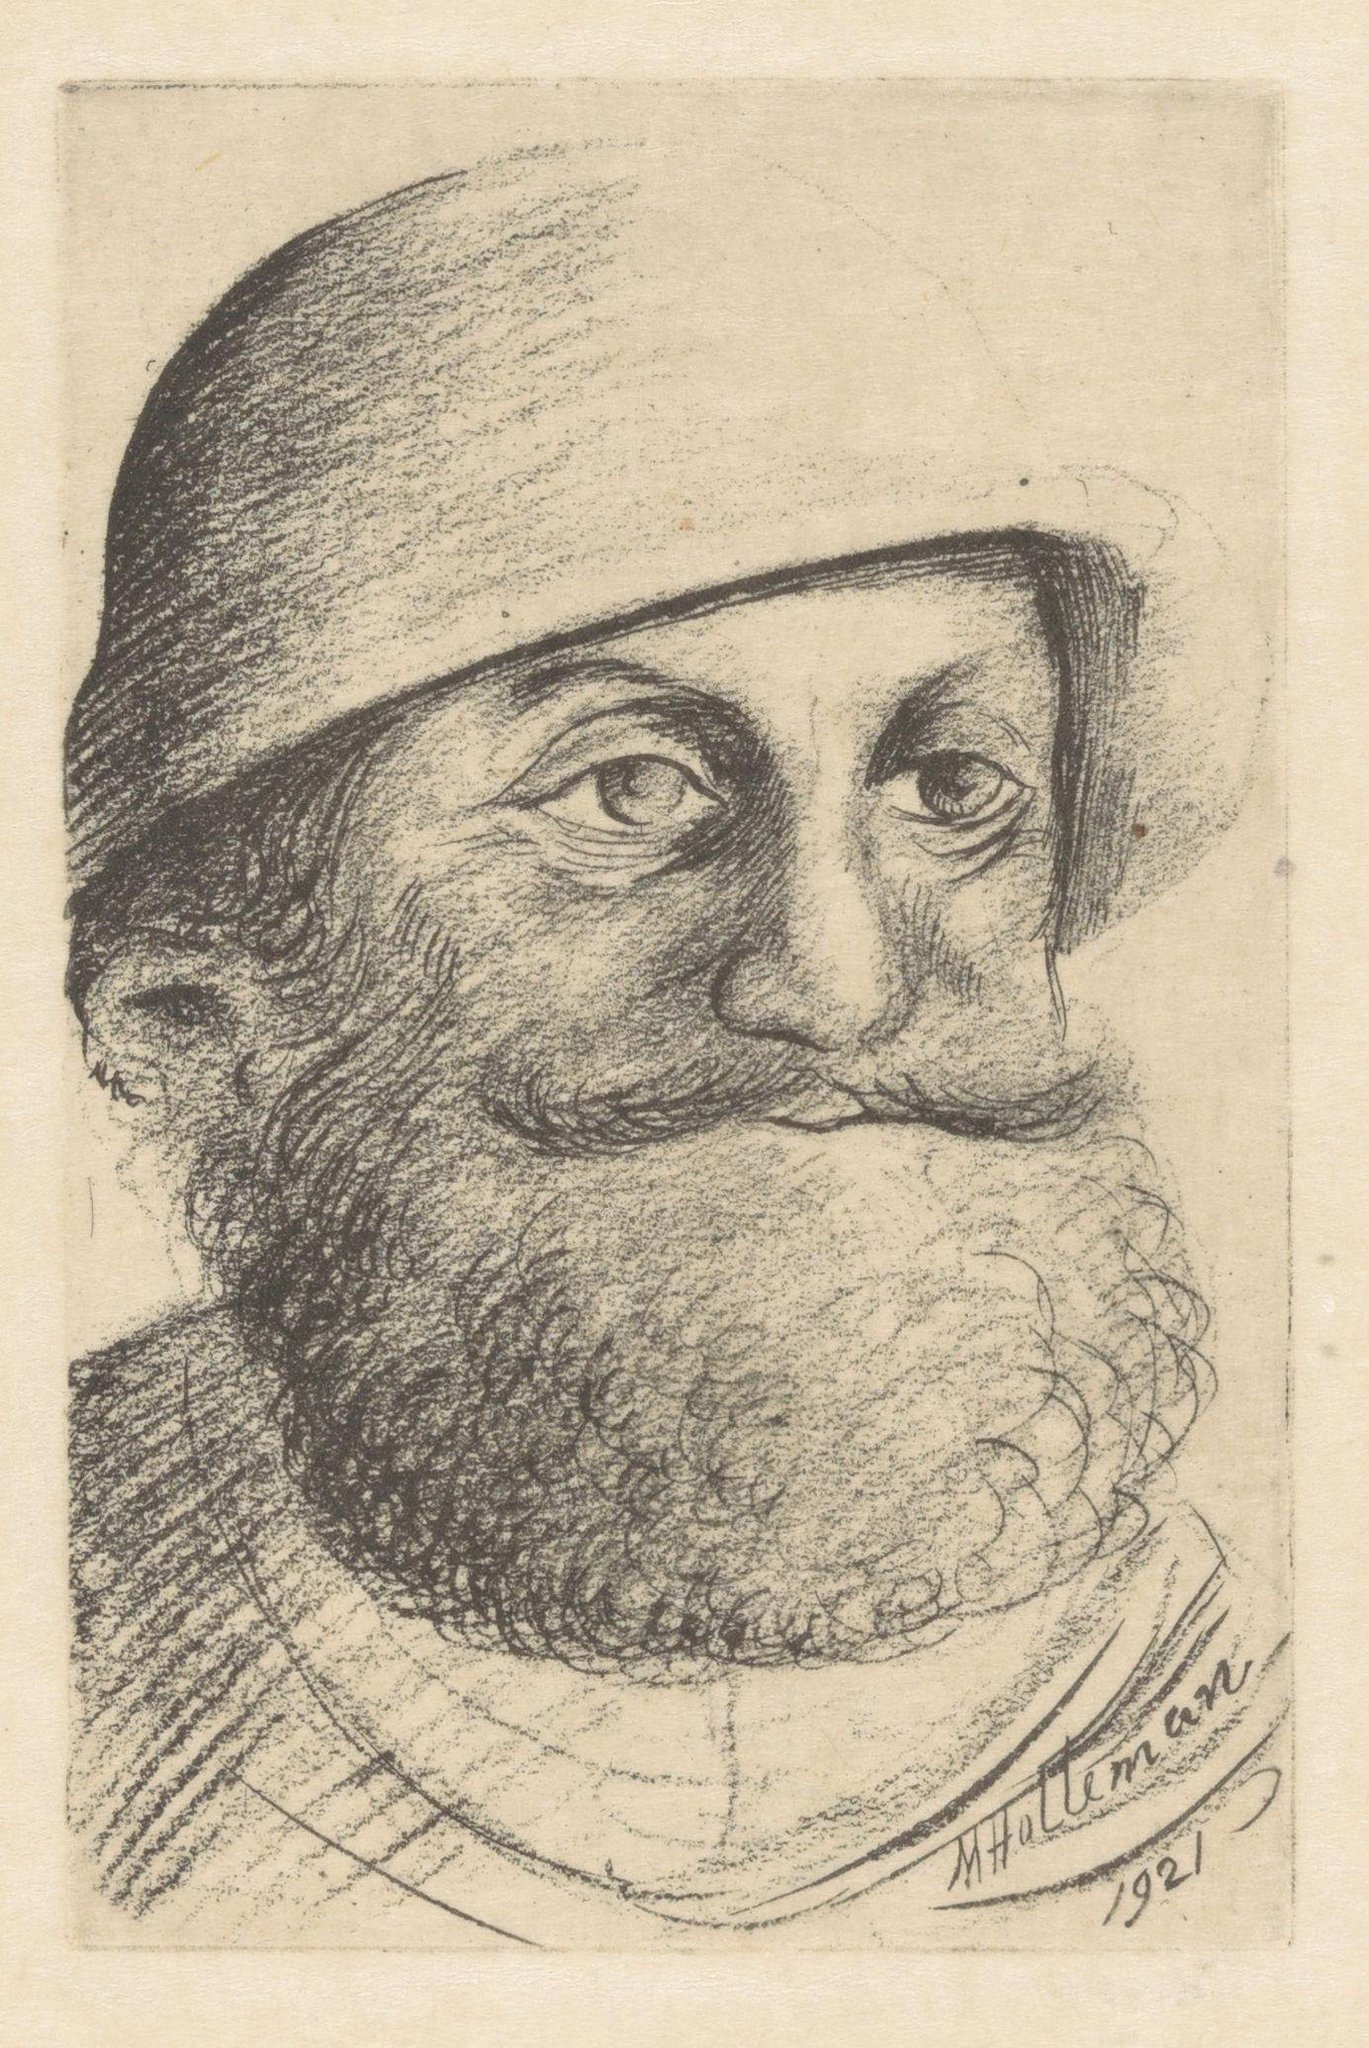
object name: print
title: Man met baard en hoed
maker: marius holleman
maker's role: draughtsman, print maker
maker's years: 1878-1926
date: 1921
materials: paper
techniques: etching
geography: groningen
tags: head-gear: hat, beard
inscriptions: collector's mark: Lugt 2228